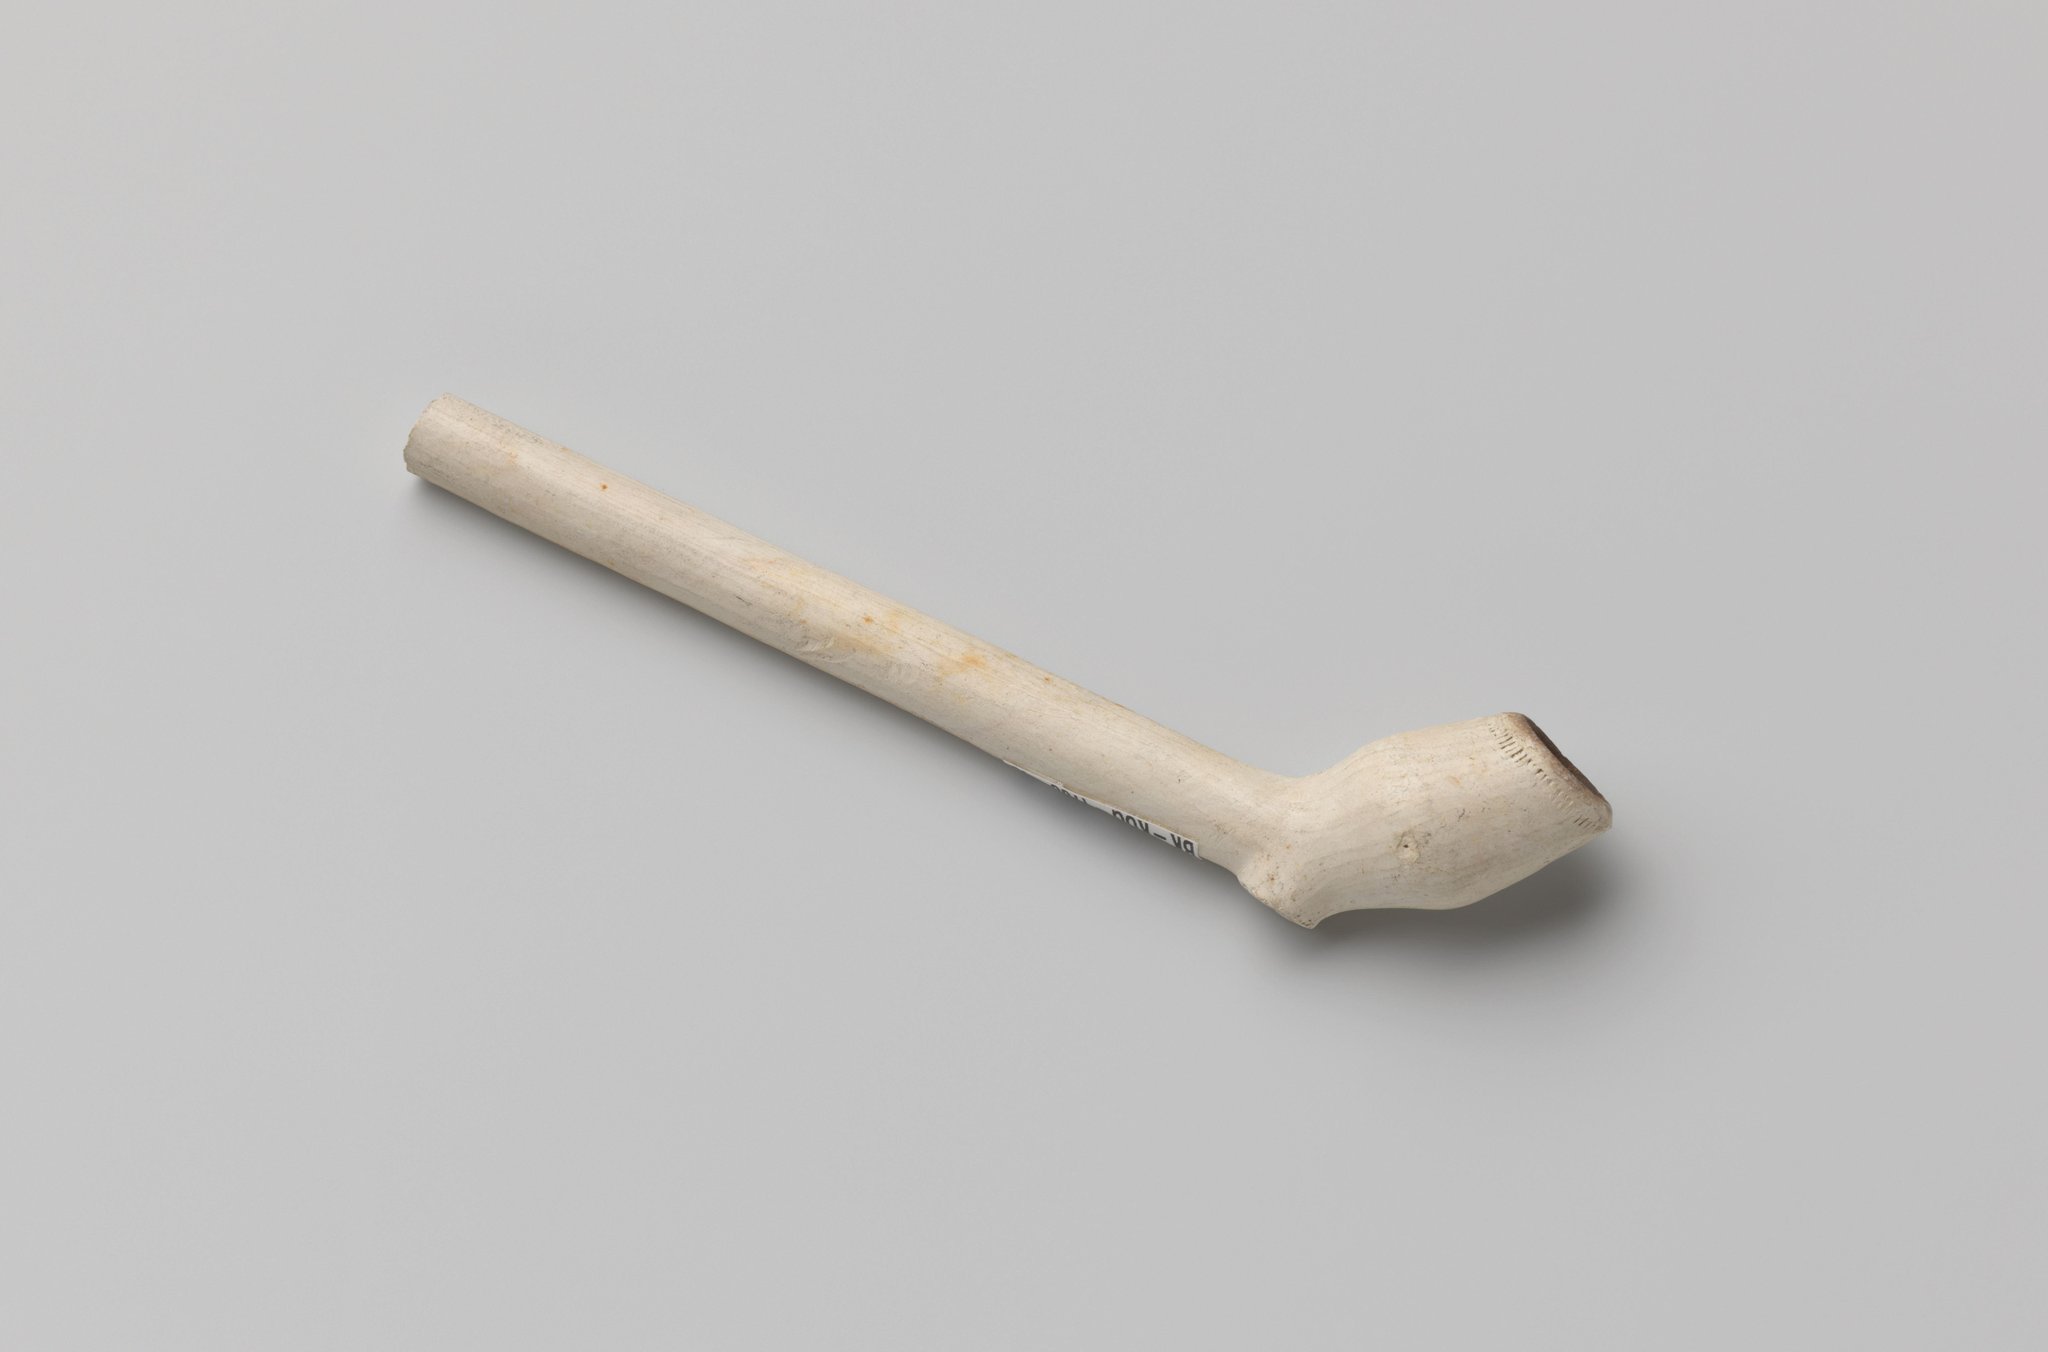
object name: tabakspijp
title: Gemerkte tabakspijp van pijpaarde, beschadigd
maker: Anonymous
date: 1500-1799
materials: clay